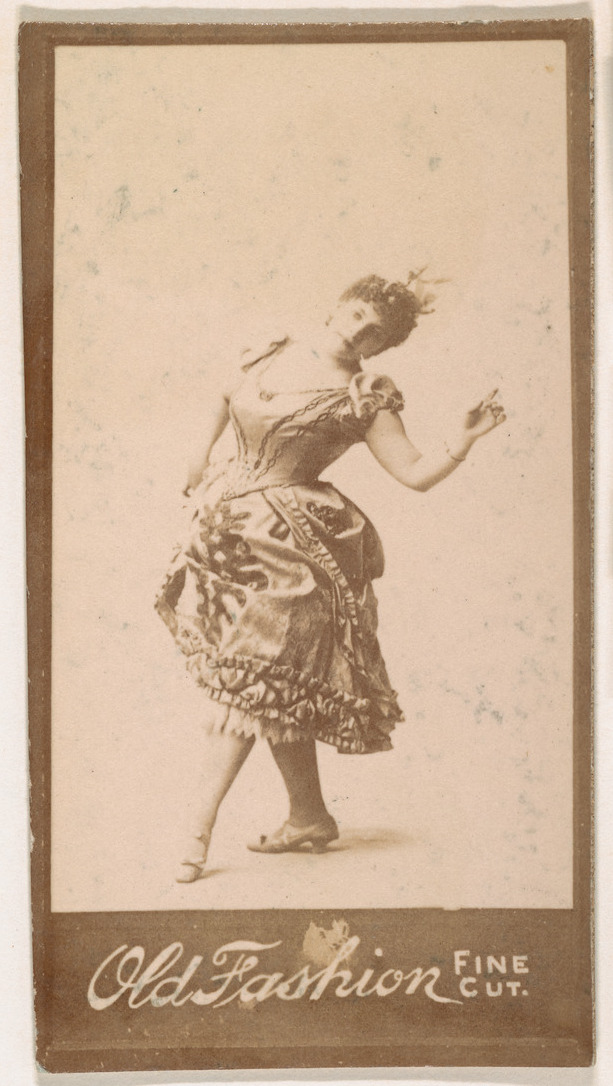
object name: photograph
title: Dancer, from the Actresses series (N664) promoting Old Fashion Fine Cut Tobacco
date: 1888-1890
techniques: albumen silver print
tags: portraits,women,dancers